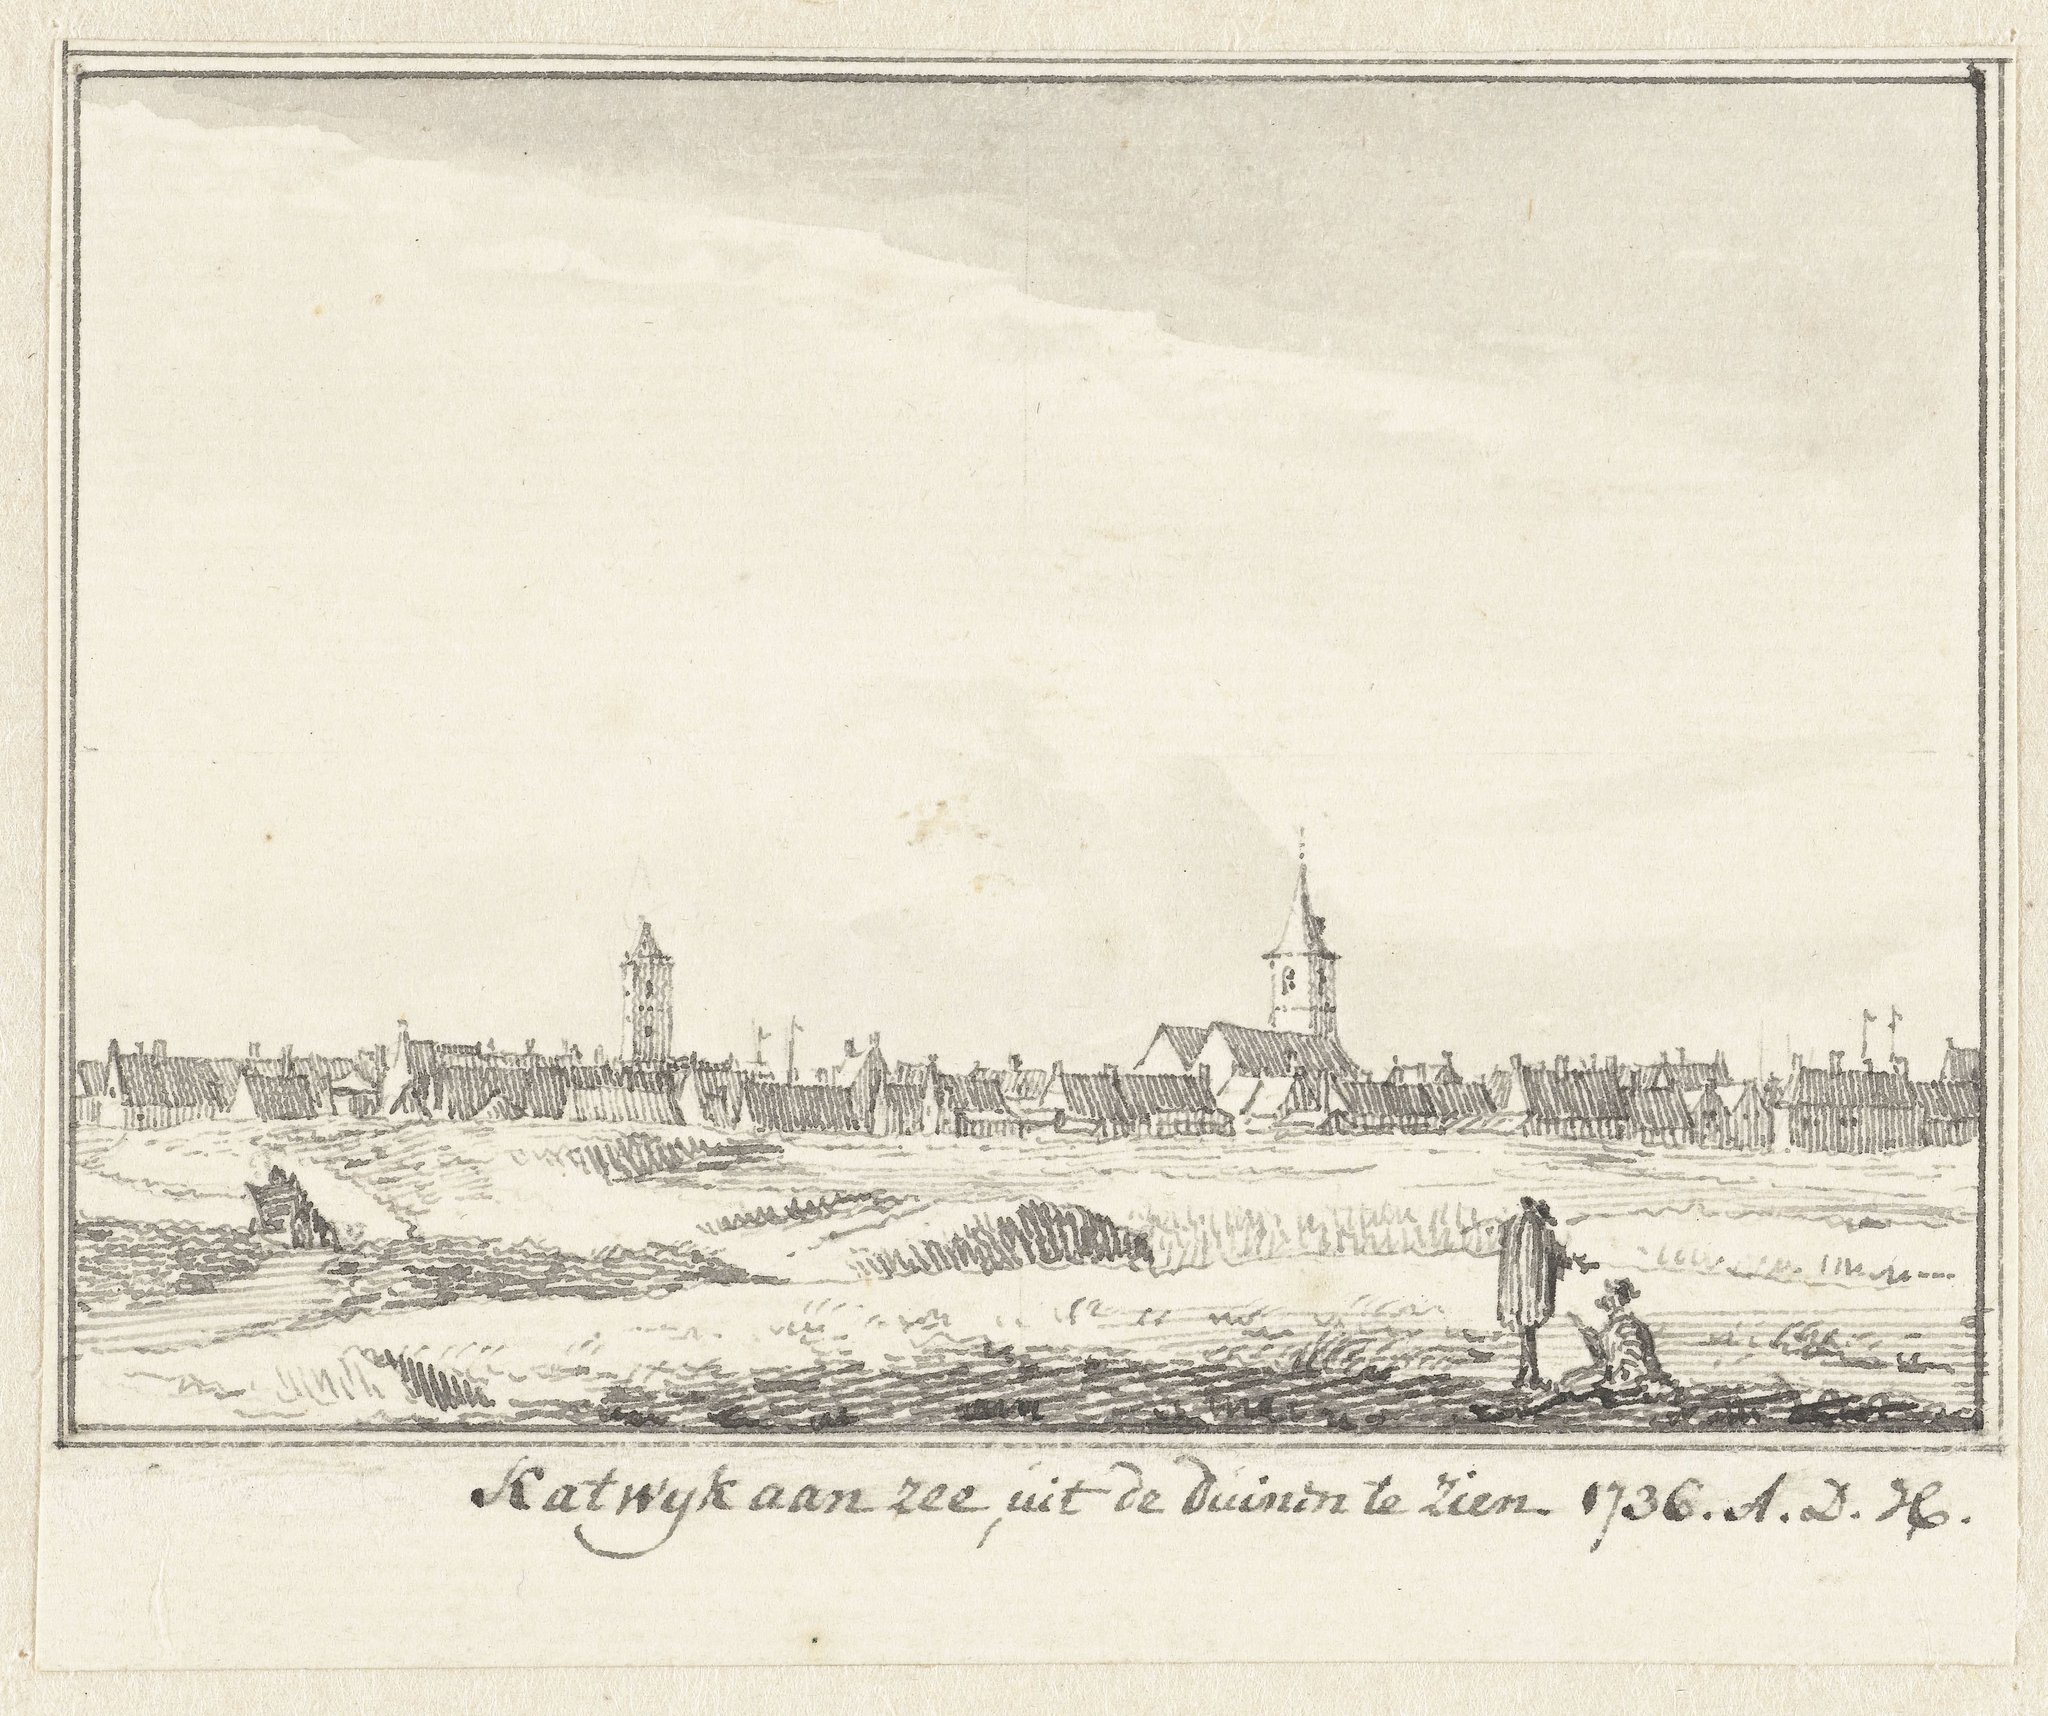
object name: drawing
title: Het dorp Katwijk aan zee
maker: hendrik spilman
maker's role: draughtsman, painter, print maker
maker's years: 1721-1784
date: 1736-1784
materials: ink, paper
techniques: brush, pen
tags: prospect of village, silhouette of village, dunes (sea not visible); in the dunes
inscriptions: inscription: ‘Katwyk aan Zee, uit de duinen te zien. 1736. A.D.H.’